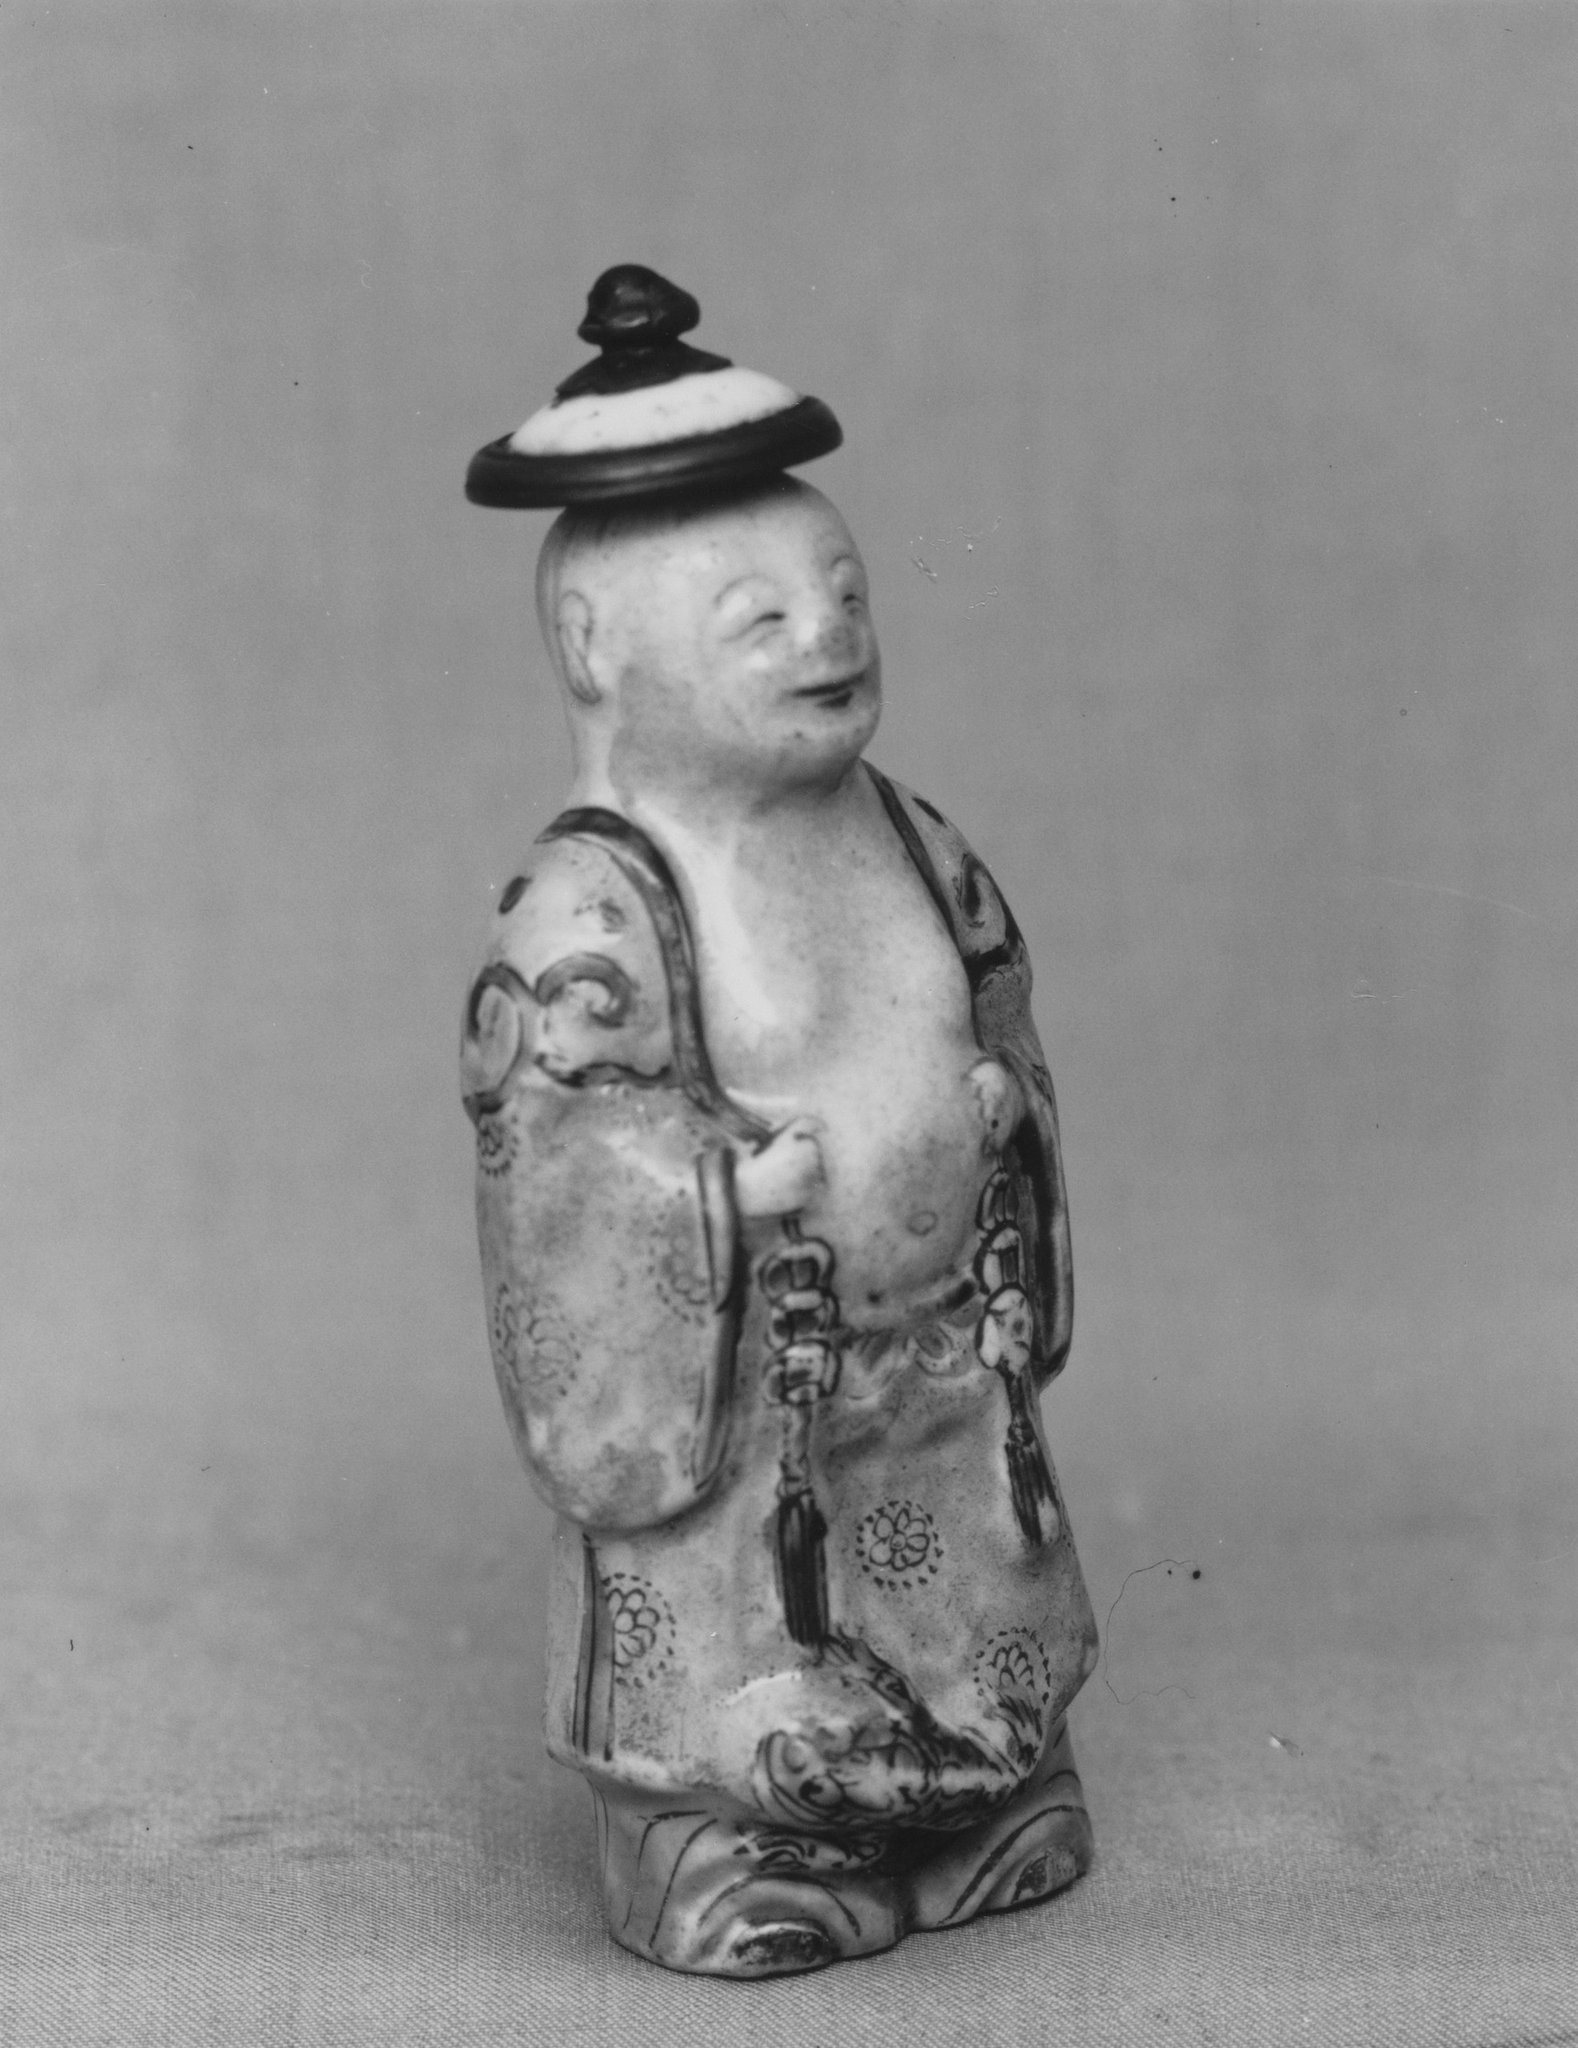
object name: snuff bottle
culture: chinese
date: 1736-1795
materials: porcelain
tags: men